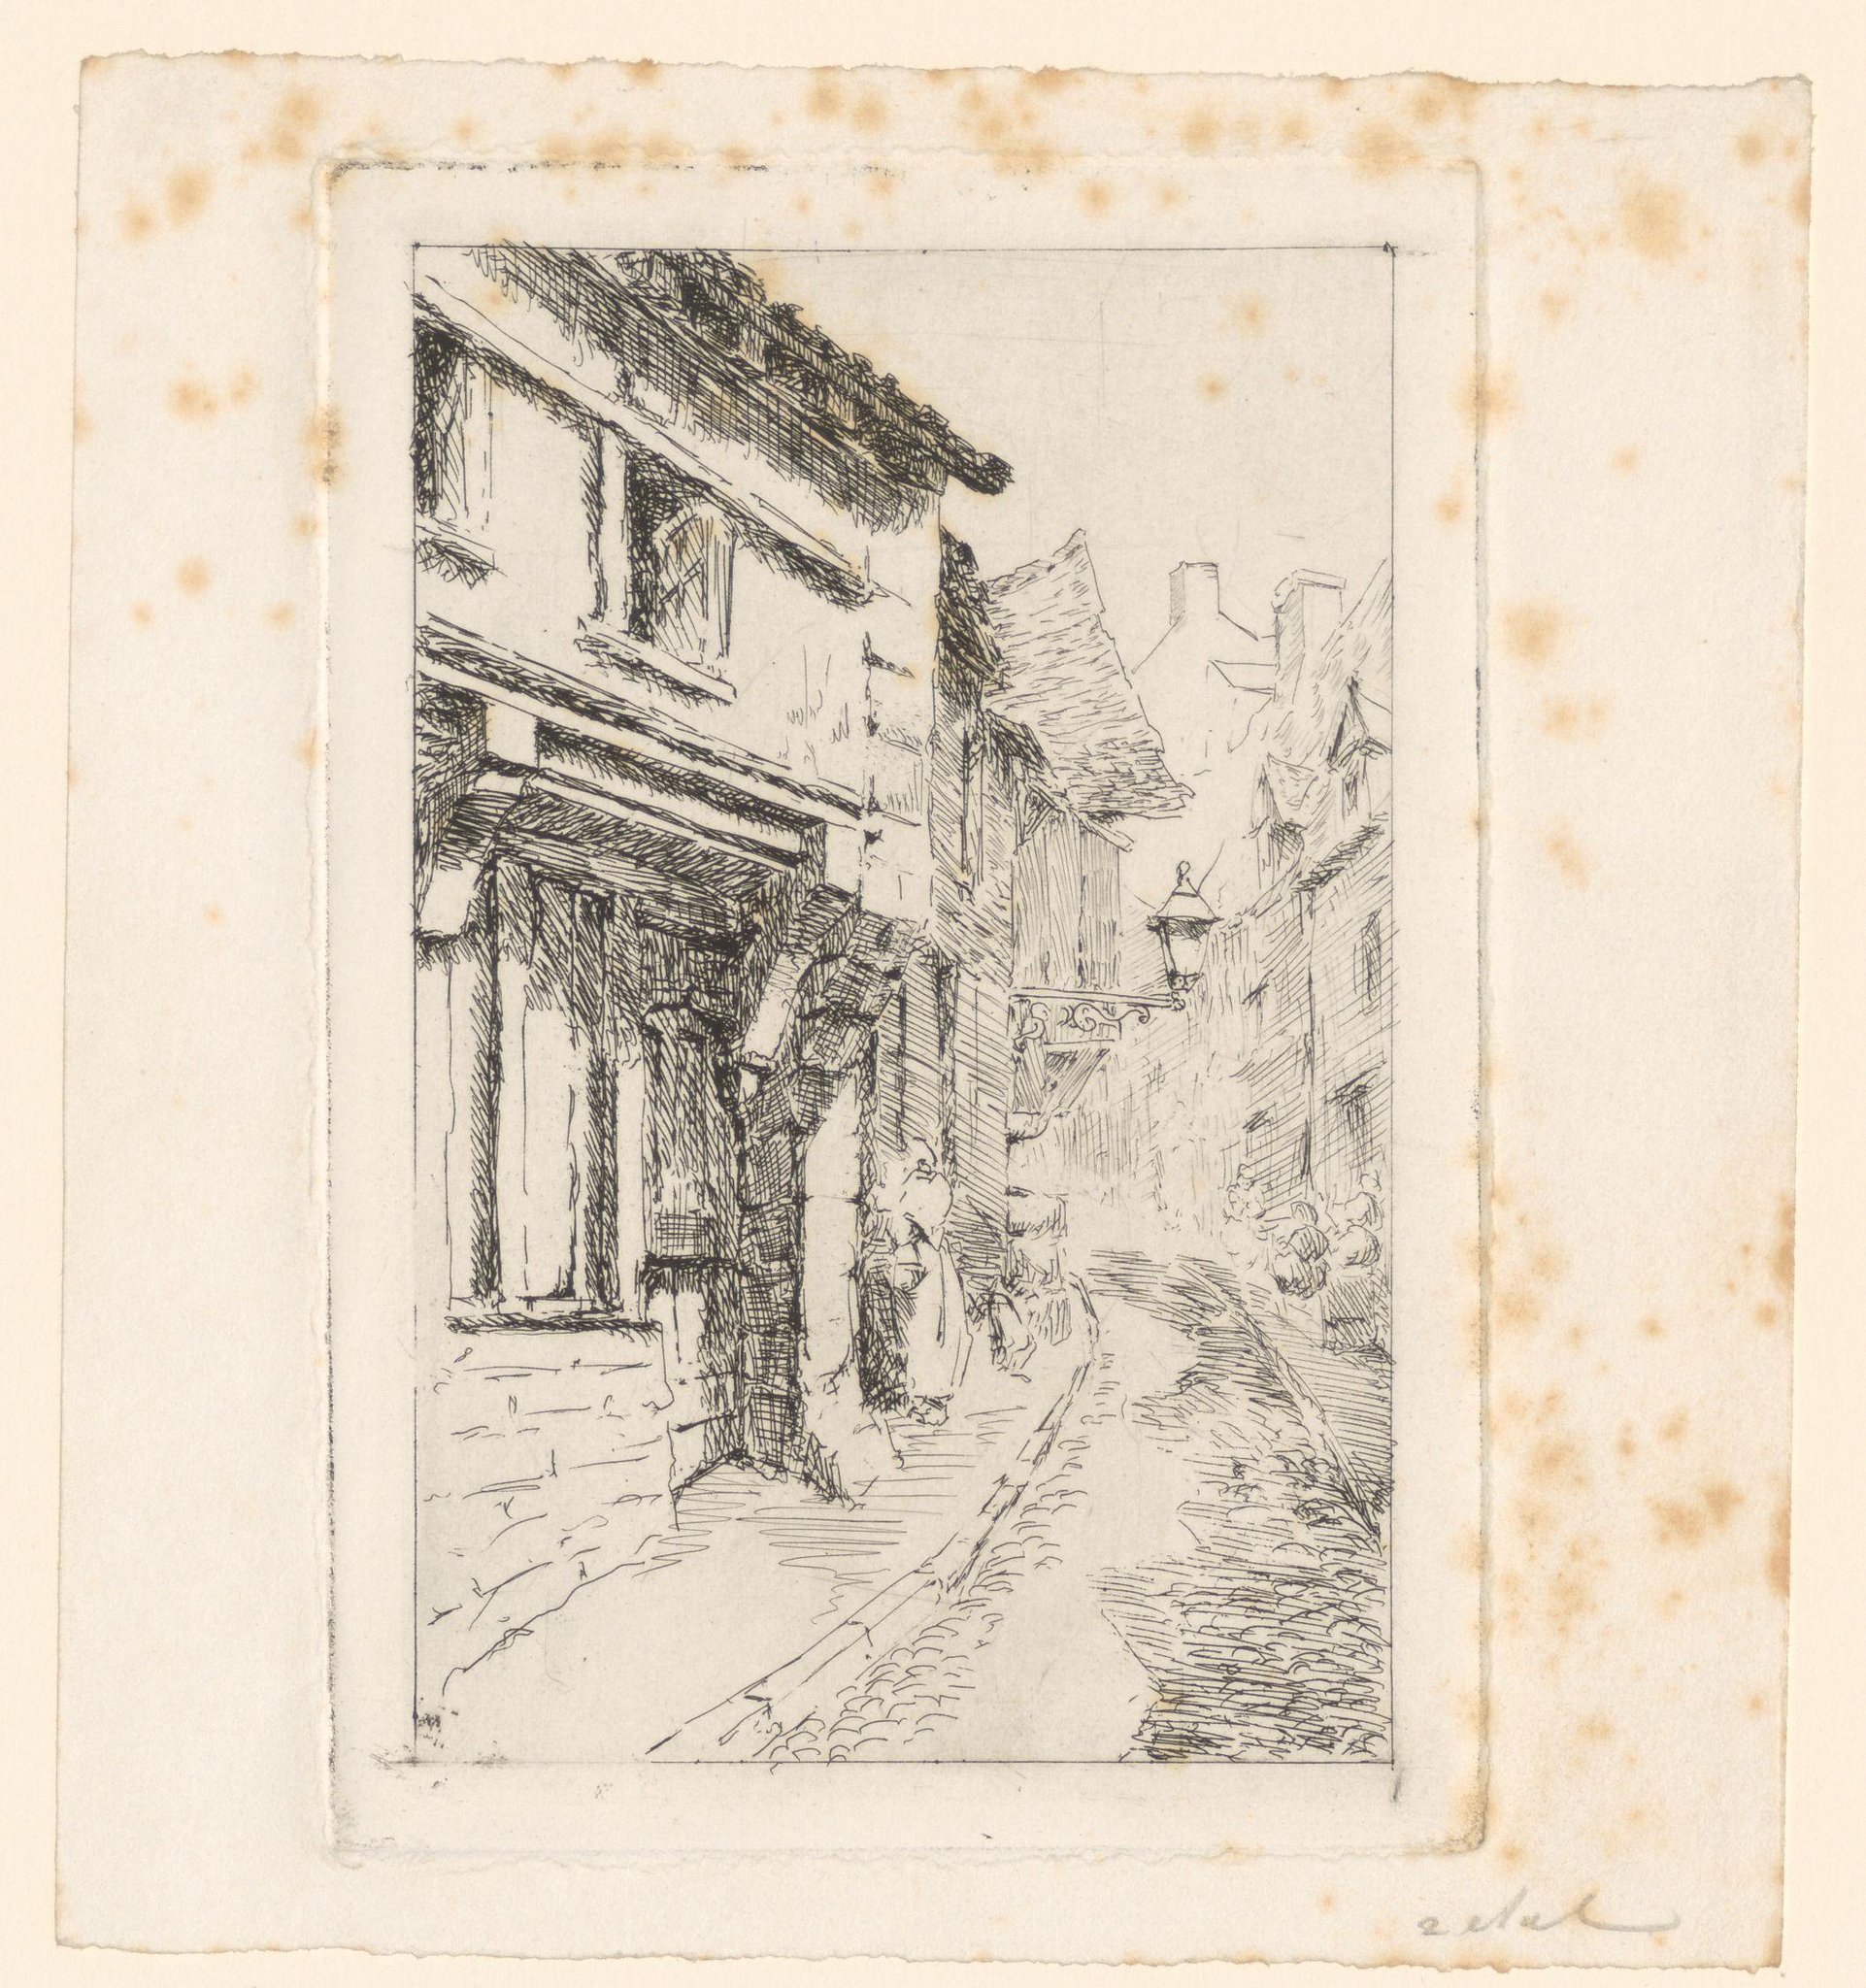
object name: print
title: Straat in bergdorp met uithangende lantaarn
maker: william spread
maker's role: print maker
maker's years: 1846-1909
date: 1879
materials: paper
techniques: etching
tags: lantern, street (+ city(-scape) with figures, staffage)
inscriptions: collector's mark: Lugt 2228